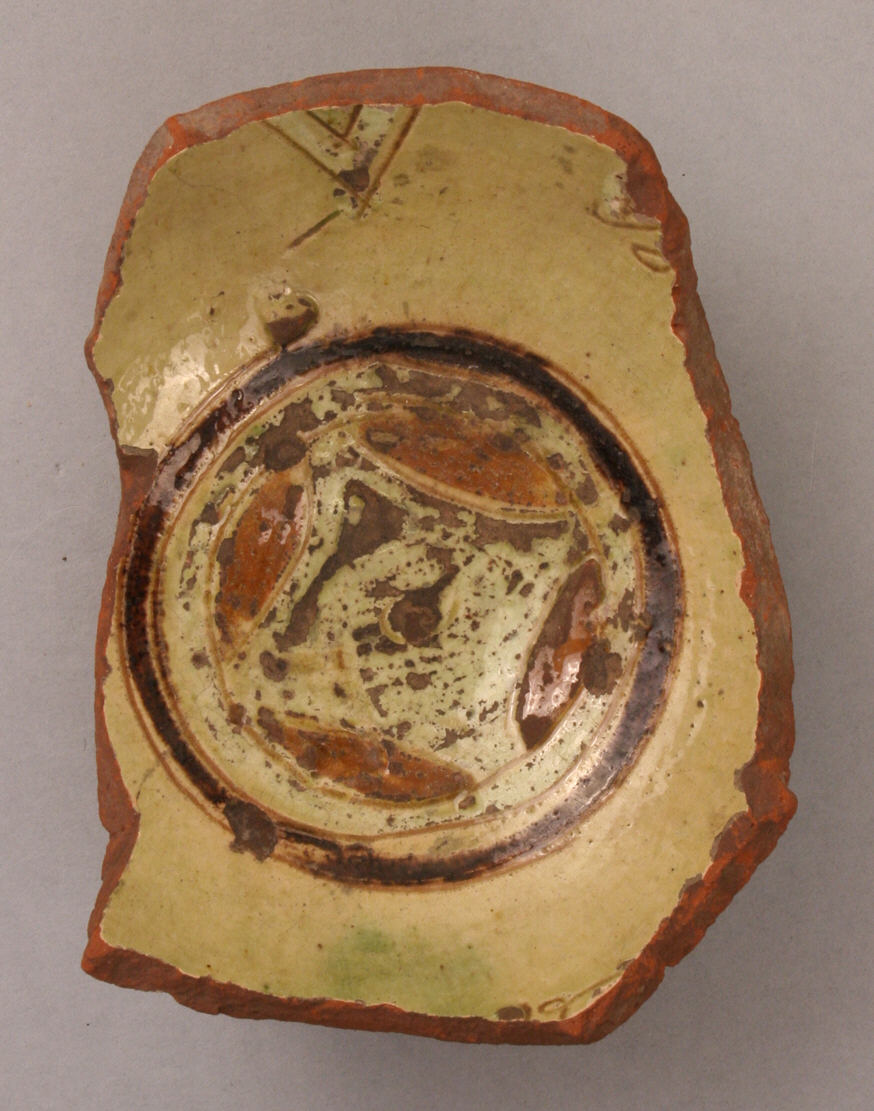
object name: fragment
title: Fragment of a Bowl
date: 1301-1500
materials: earthenware, glaze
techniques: coloring, incising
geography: egypt